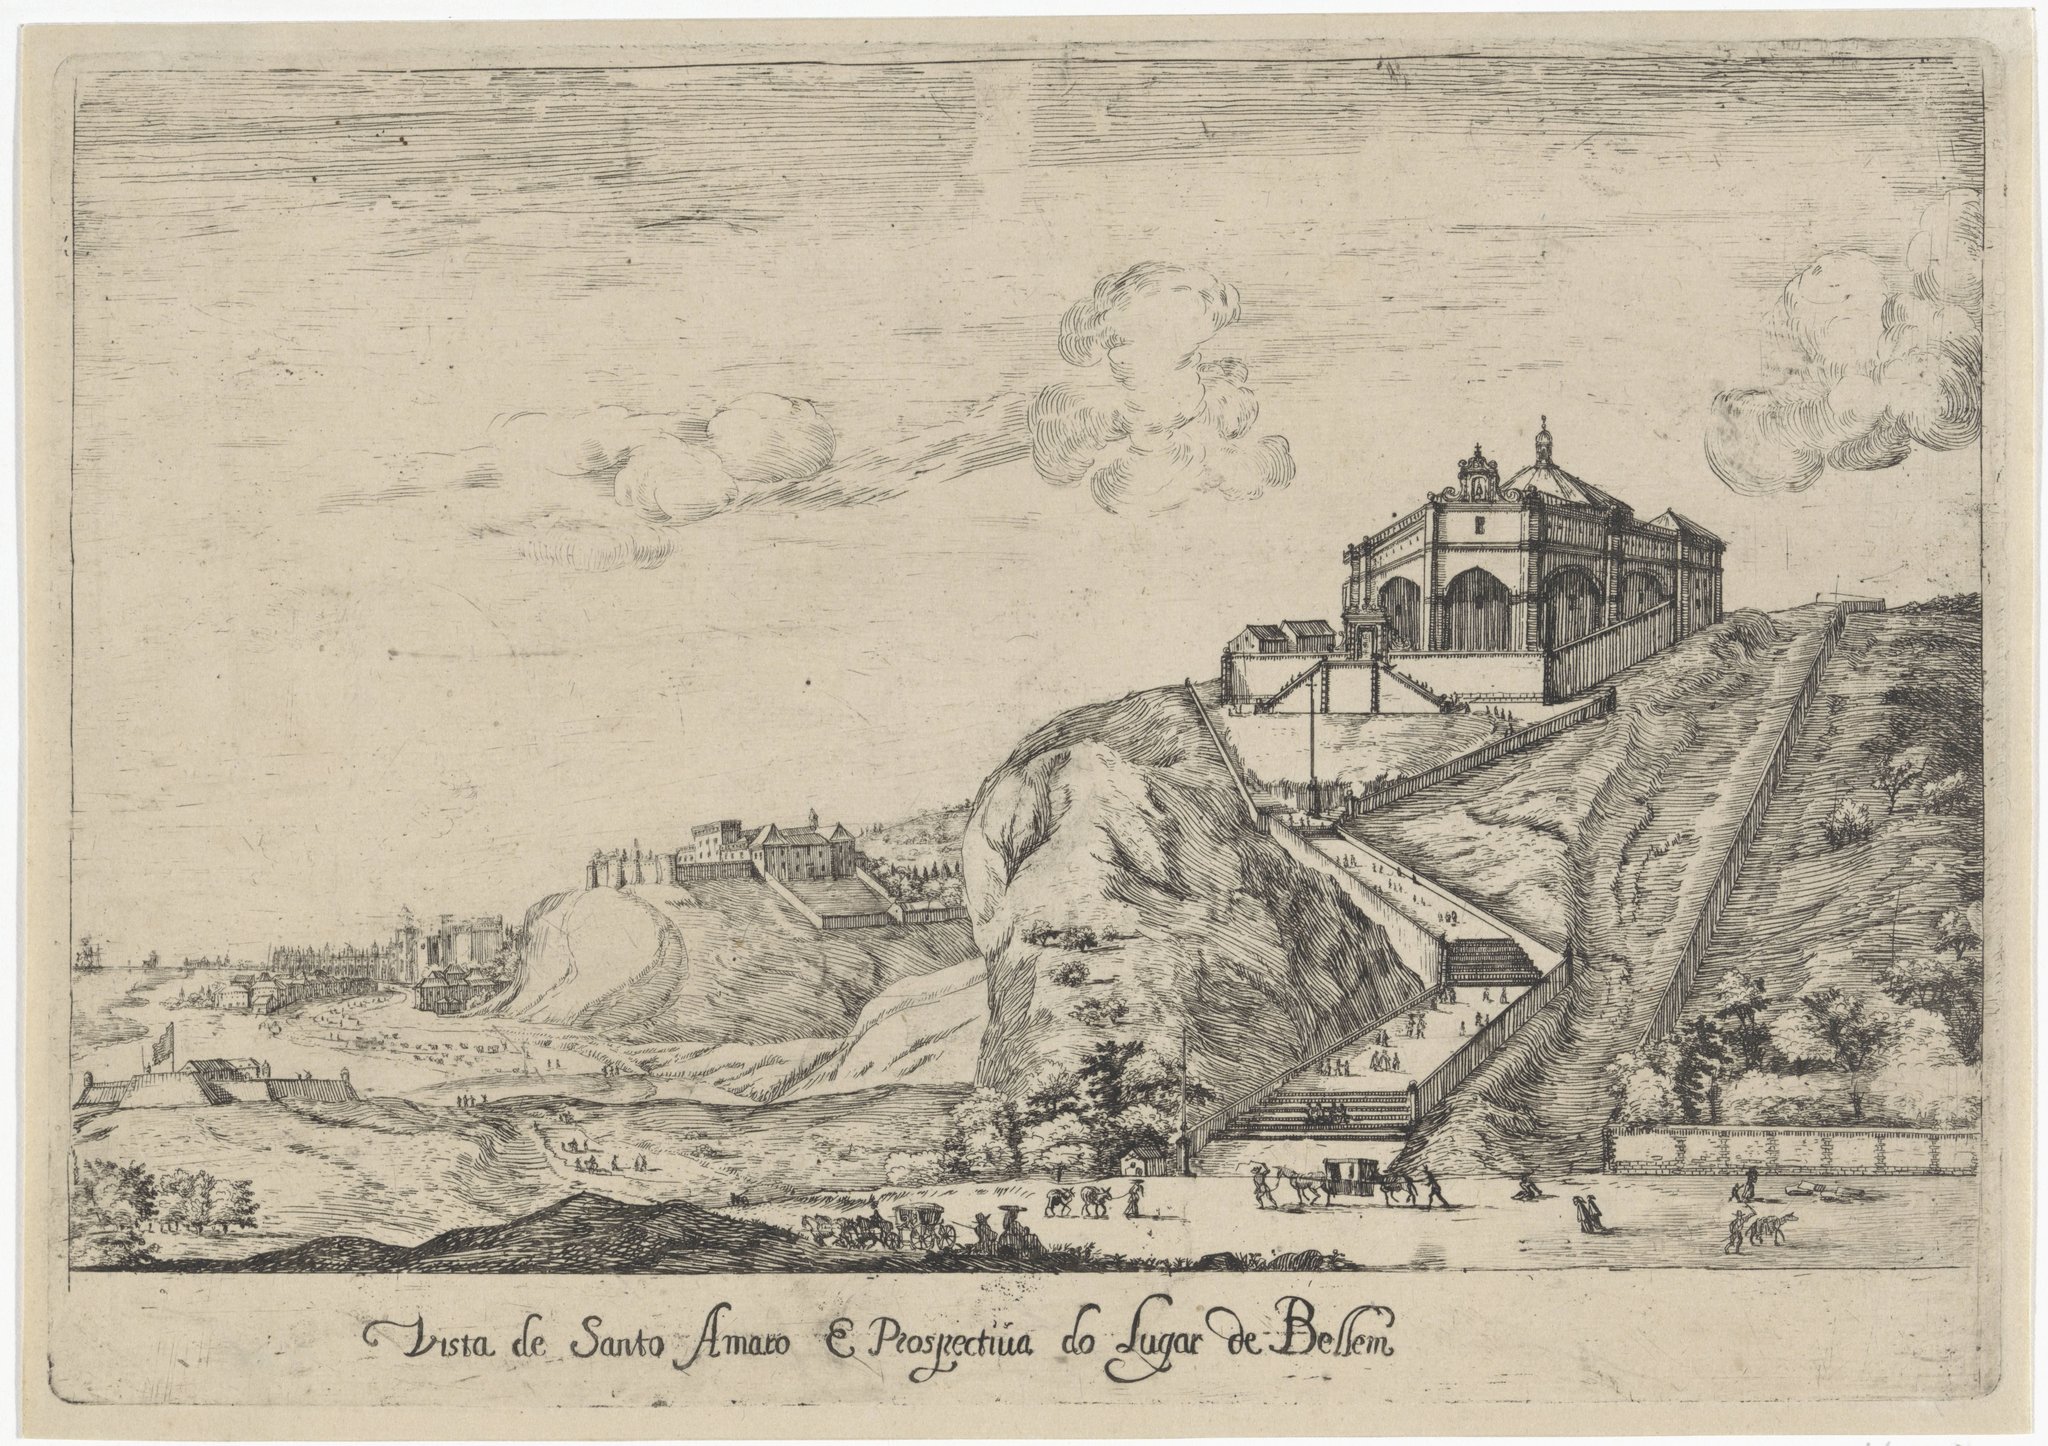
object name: print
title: Gezichten op Lissabon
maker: dirk stoop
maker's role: draughtsman, painter, print maker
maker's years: 1615-1686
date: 1662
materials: paper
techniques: etching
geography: lisbon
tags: landscapes in the temperate zone, church (exterior)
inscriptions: collector's mark: Lugt 2228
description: Gezicht op de op een heuvel gelegen kerk van Santo Amaro, gezien vanaf de toren van Belém. Trappen leiden naar de kerk. Op de achtergrond links de stad Lissabon en de rivier de Taag.